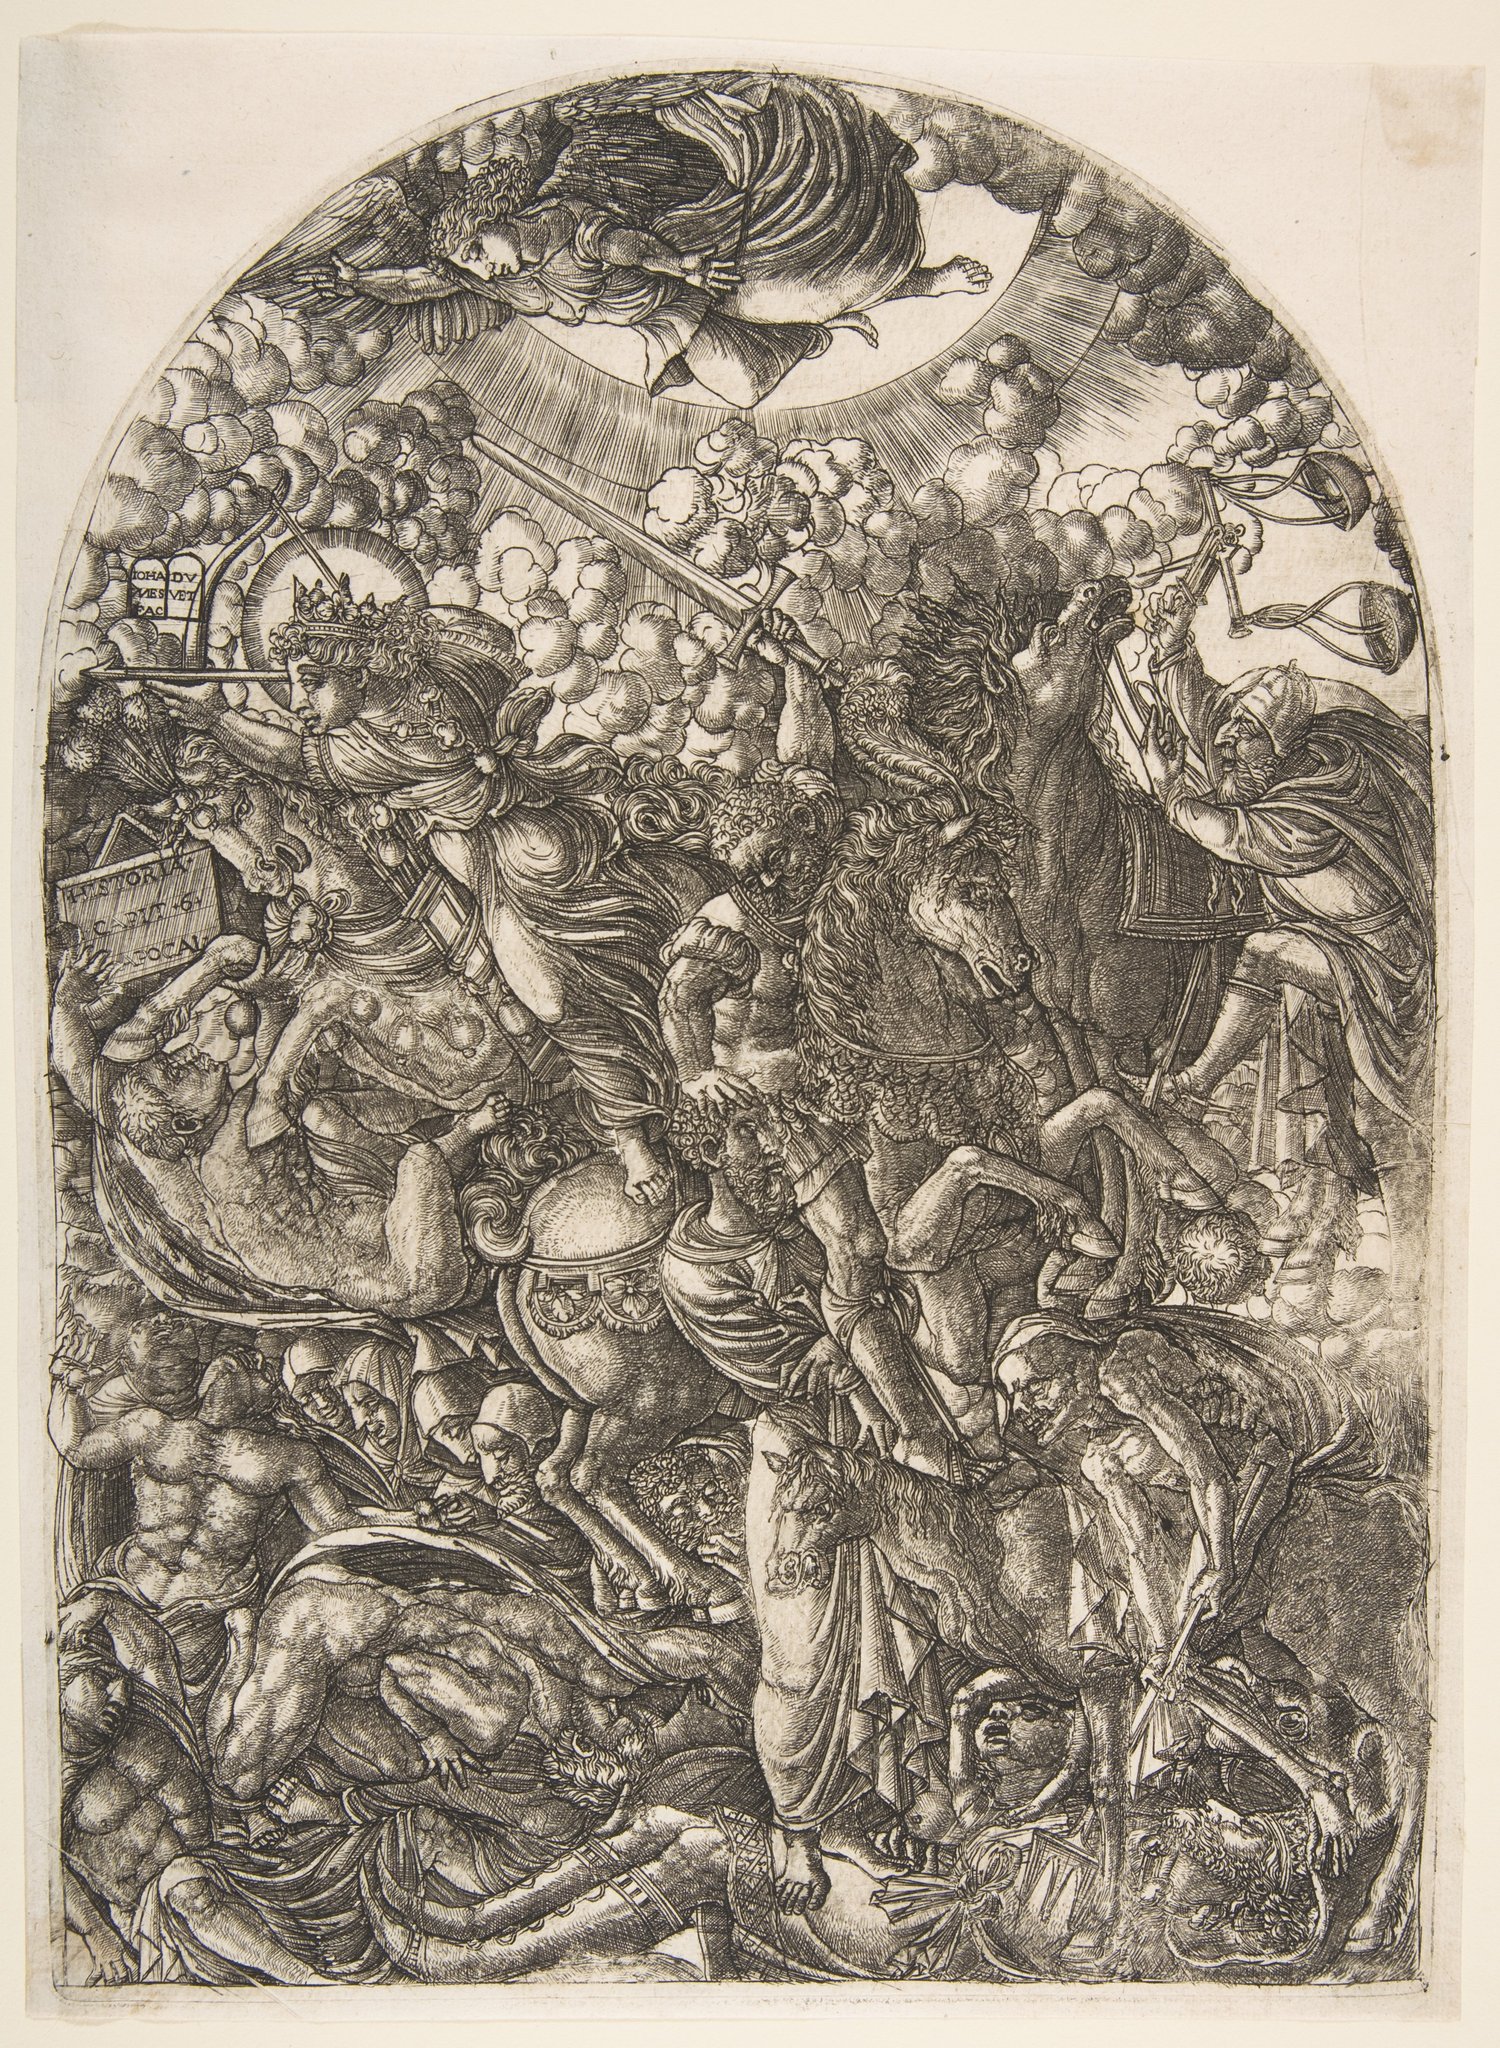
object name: print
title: Saint John sees the Four Horsemen, from the Apocalyspe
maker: jean duvet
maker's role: artist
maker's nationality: french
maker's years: 1485-1561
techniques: engraving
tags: men,horses,saint john the evangelist